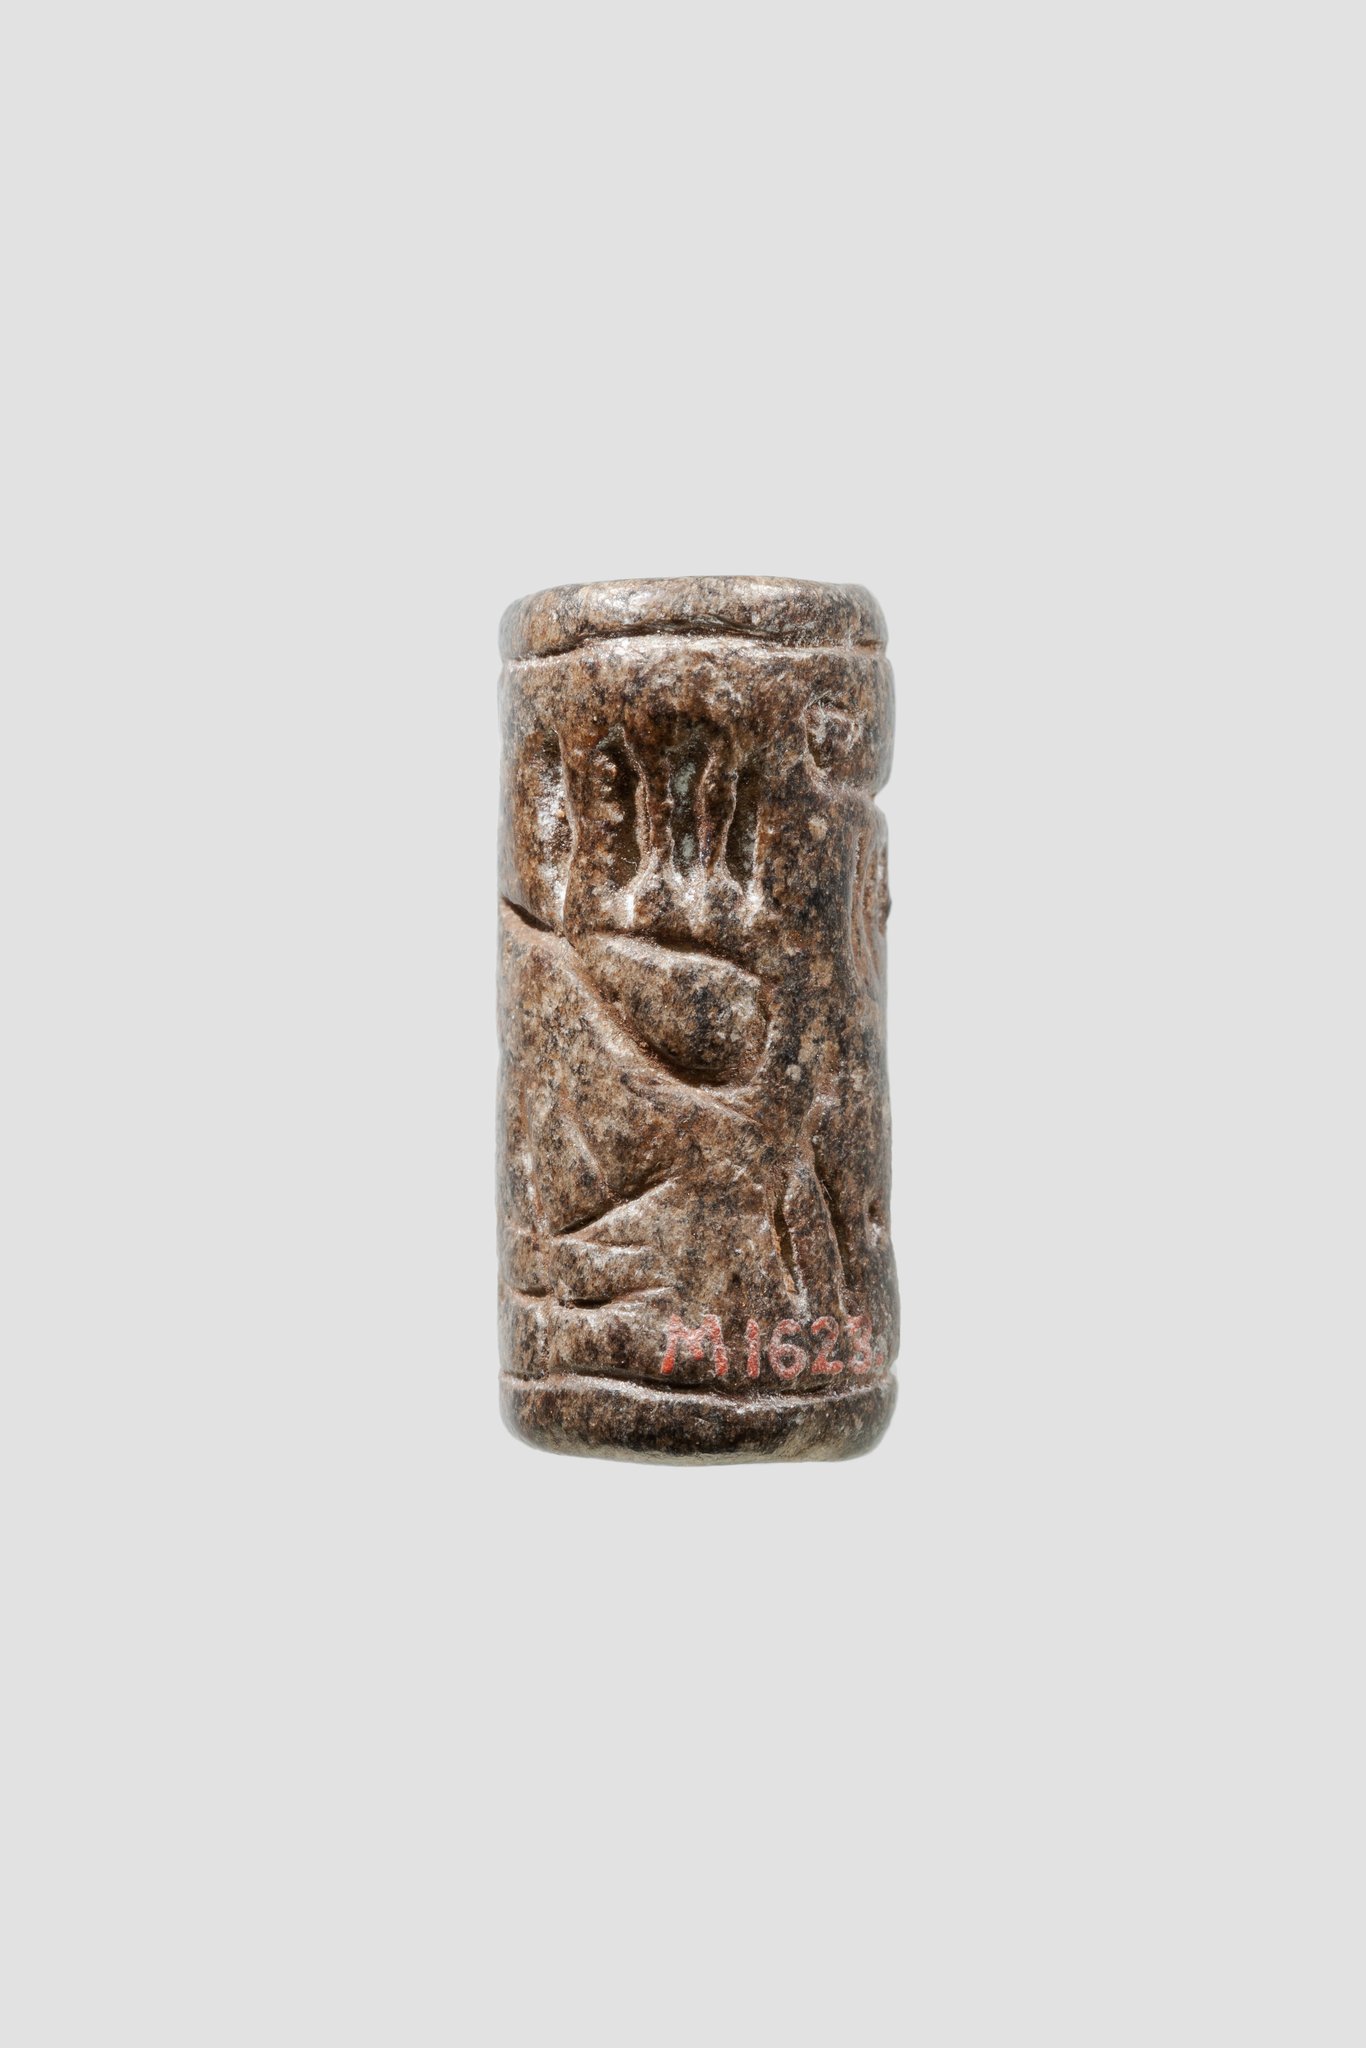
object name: cylinder seal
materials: stone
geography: egypt